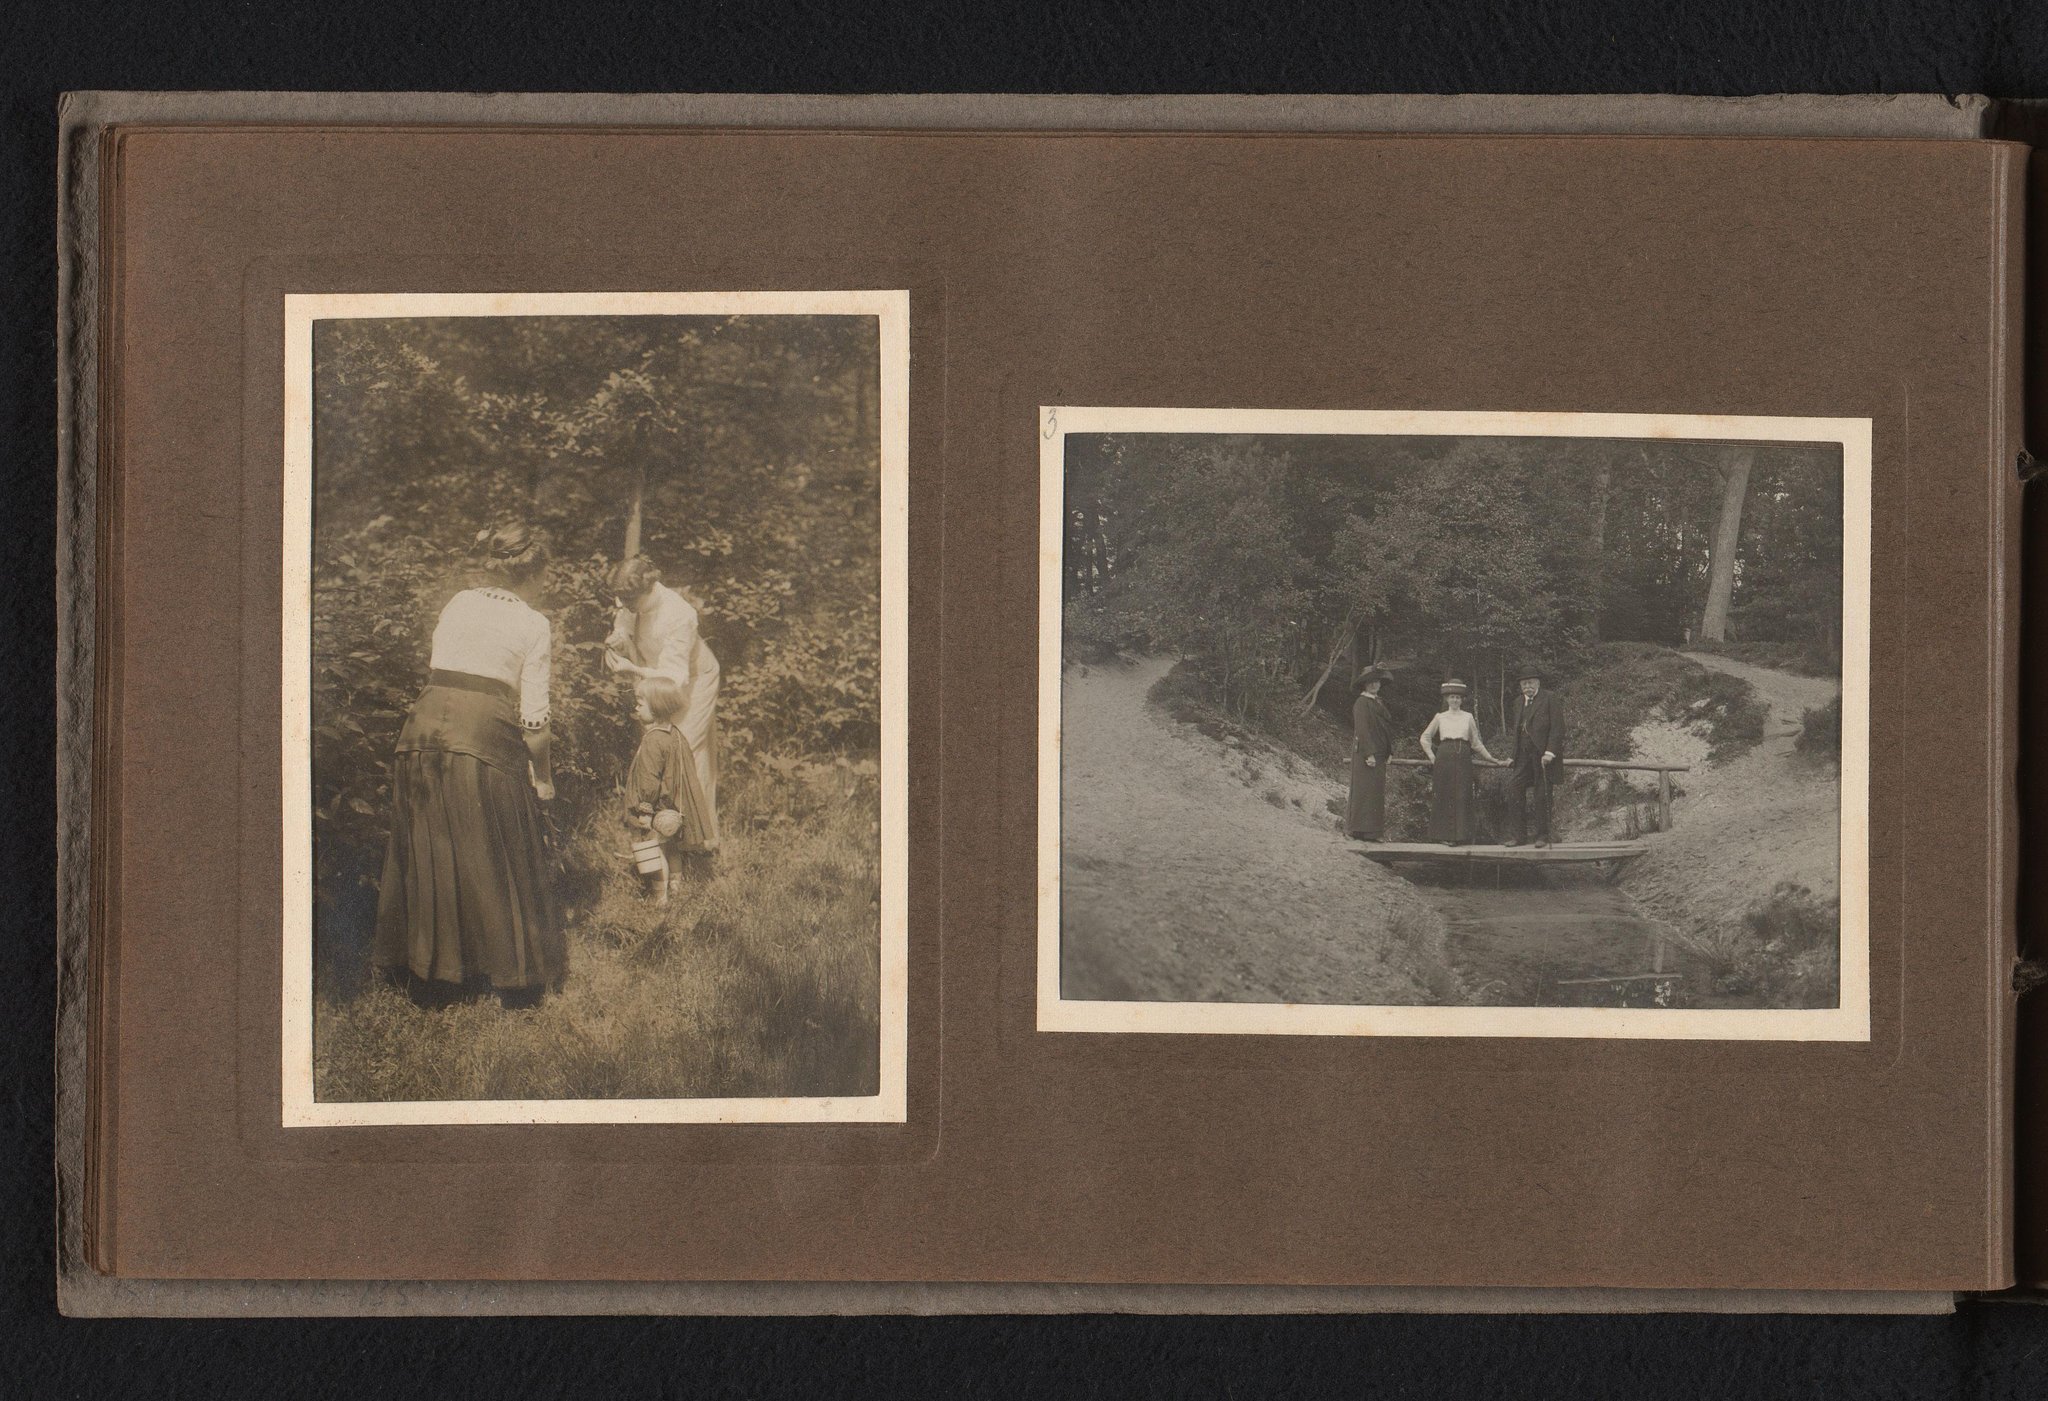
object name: photograph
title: Familie van den Berg in Klarenbeek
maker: hendrik herman van den berg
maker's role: amateurfotograaf, jurist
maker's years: 1875-1944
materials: paper, cardboard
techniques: gelatin silver print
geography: klarenbeek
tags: amsterdam, carel frederik van den berg (cay), family life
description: Deze foto's zijn onderdeel van een album.